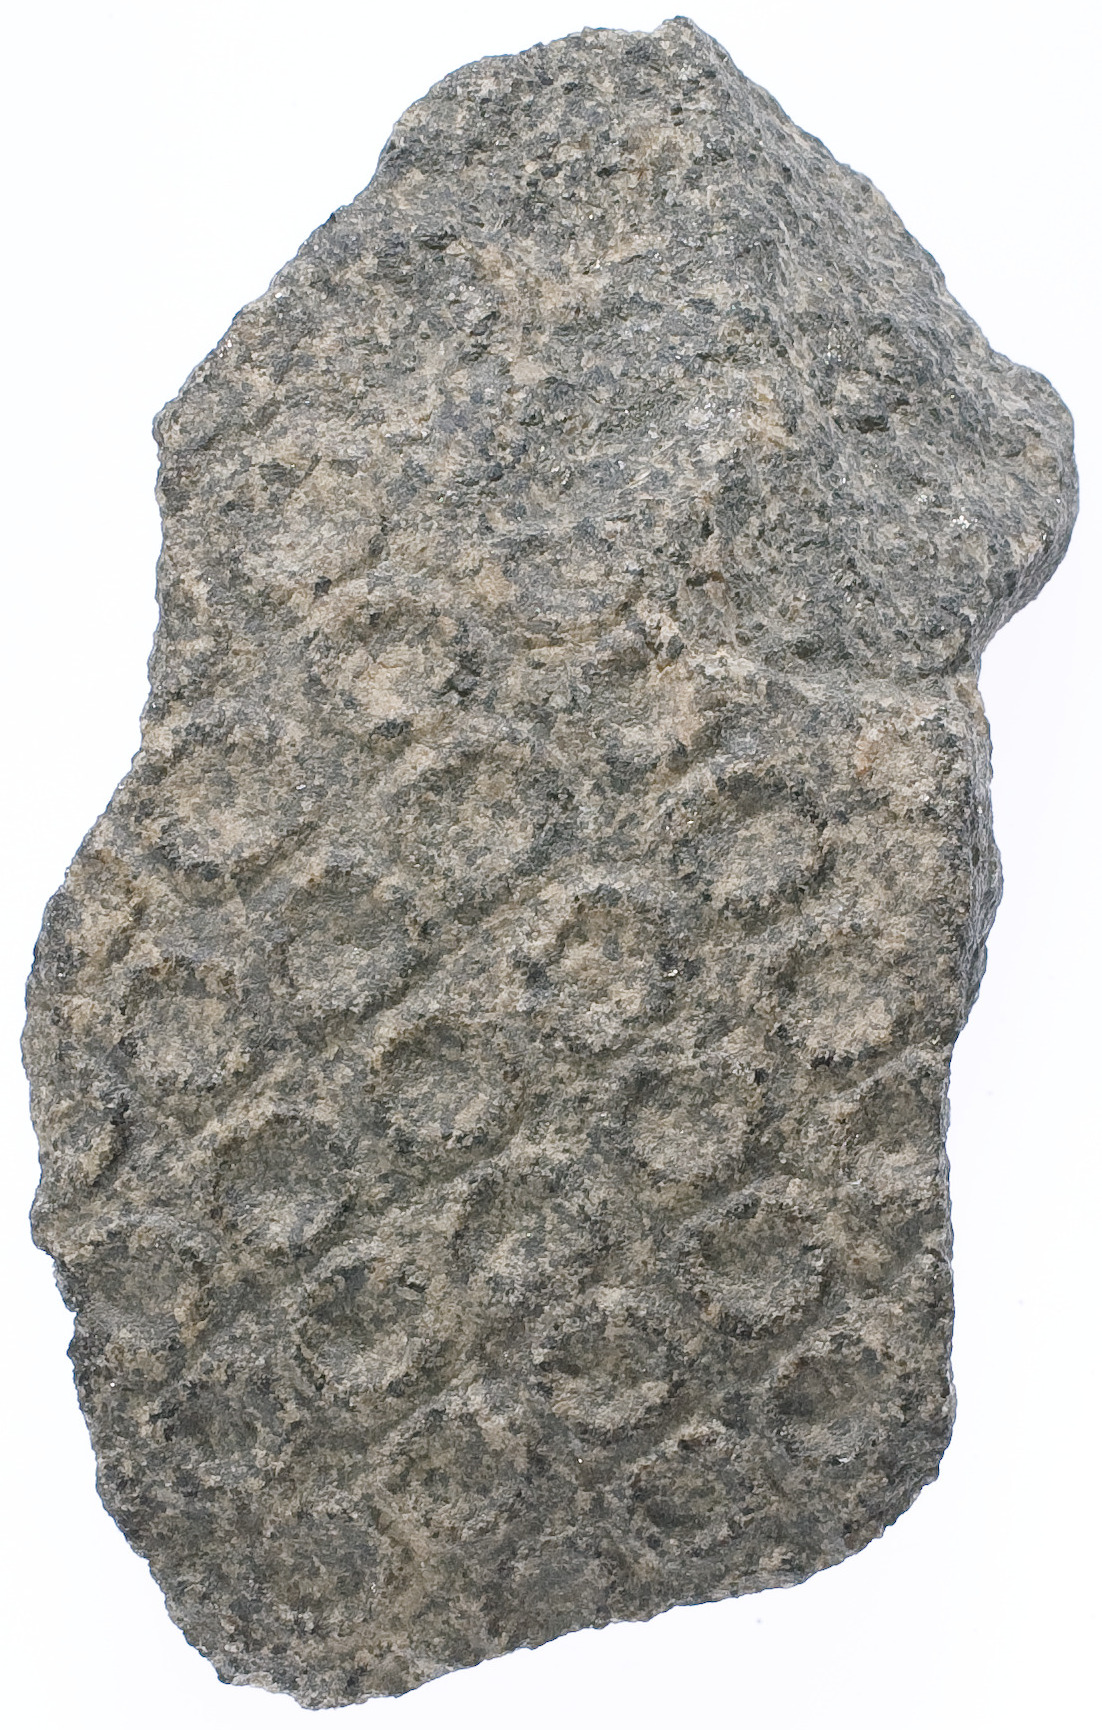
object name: crown with disc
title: Crown with disks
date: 1353-1336 BCE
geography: egypt